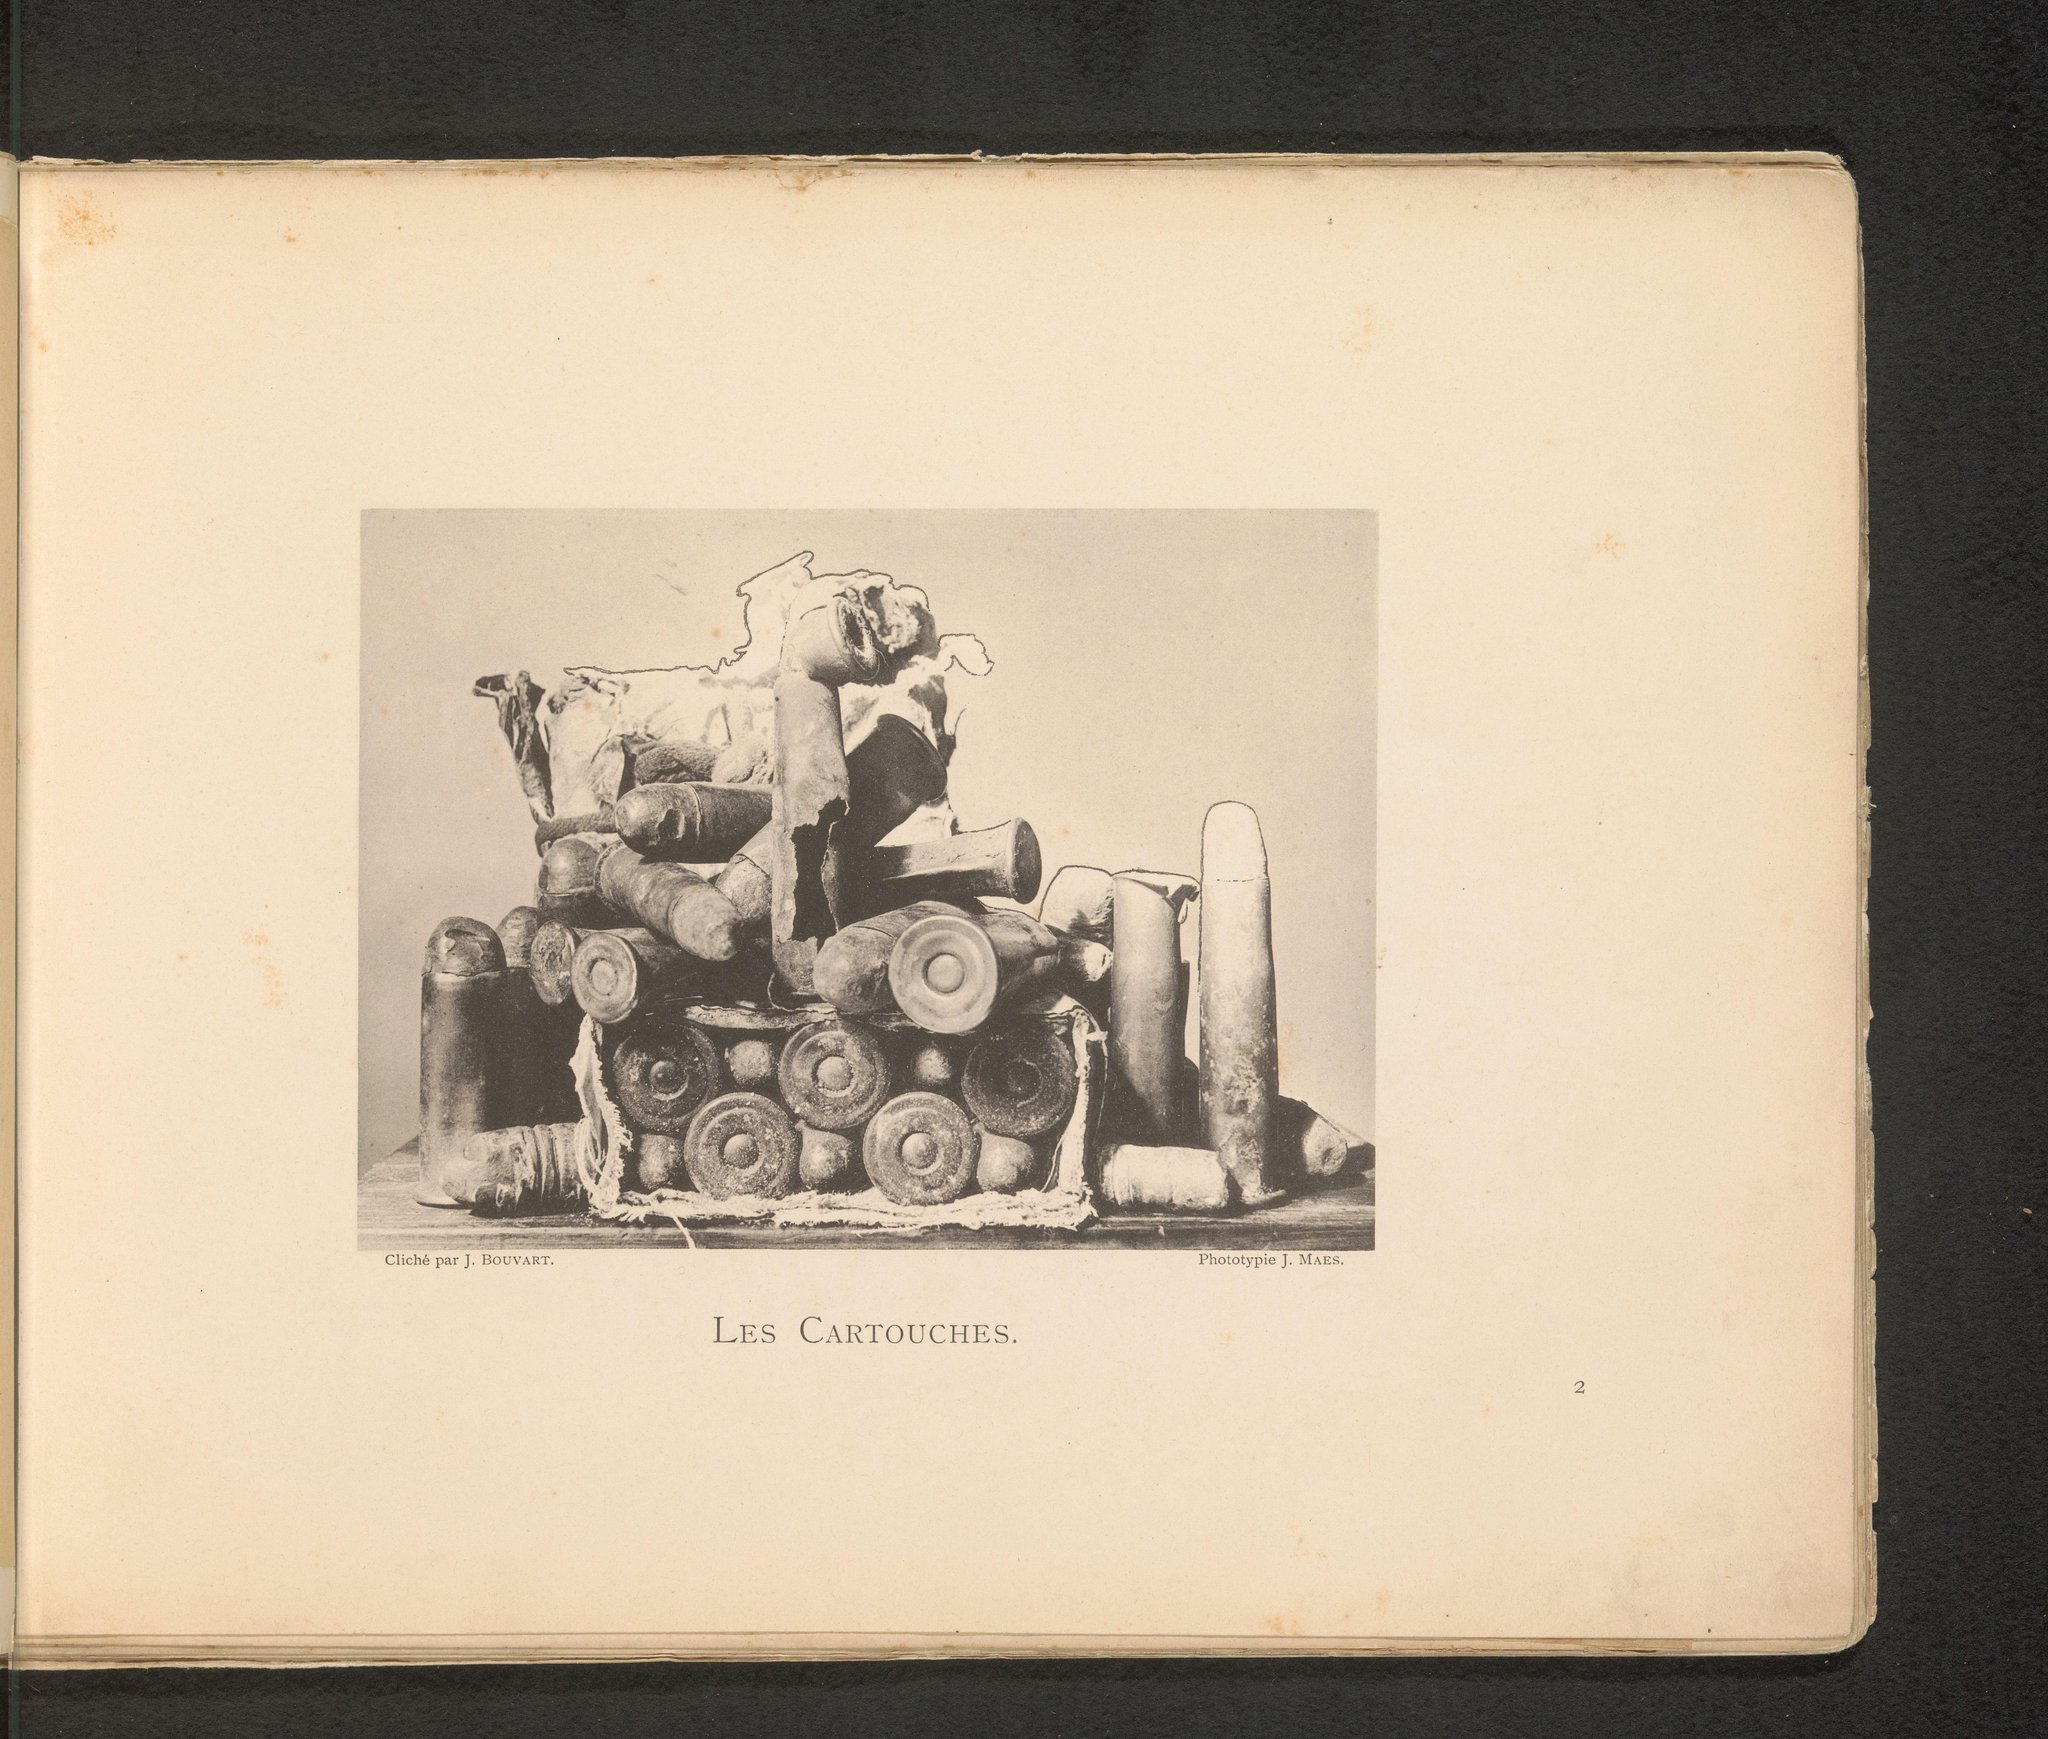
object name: page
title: Munitiepatronen na de ontploffing van een munitiefabriek in Oosterweel bij Antwerpen op 6 september 1889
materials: paper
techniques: photograph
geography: oosterweel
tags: projectiles, explosives, etc.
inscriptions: number: ‘2’